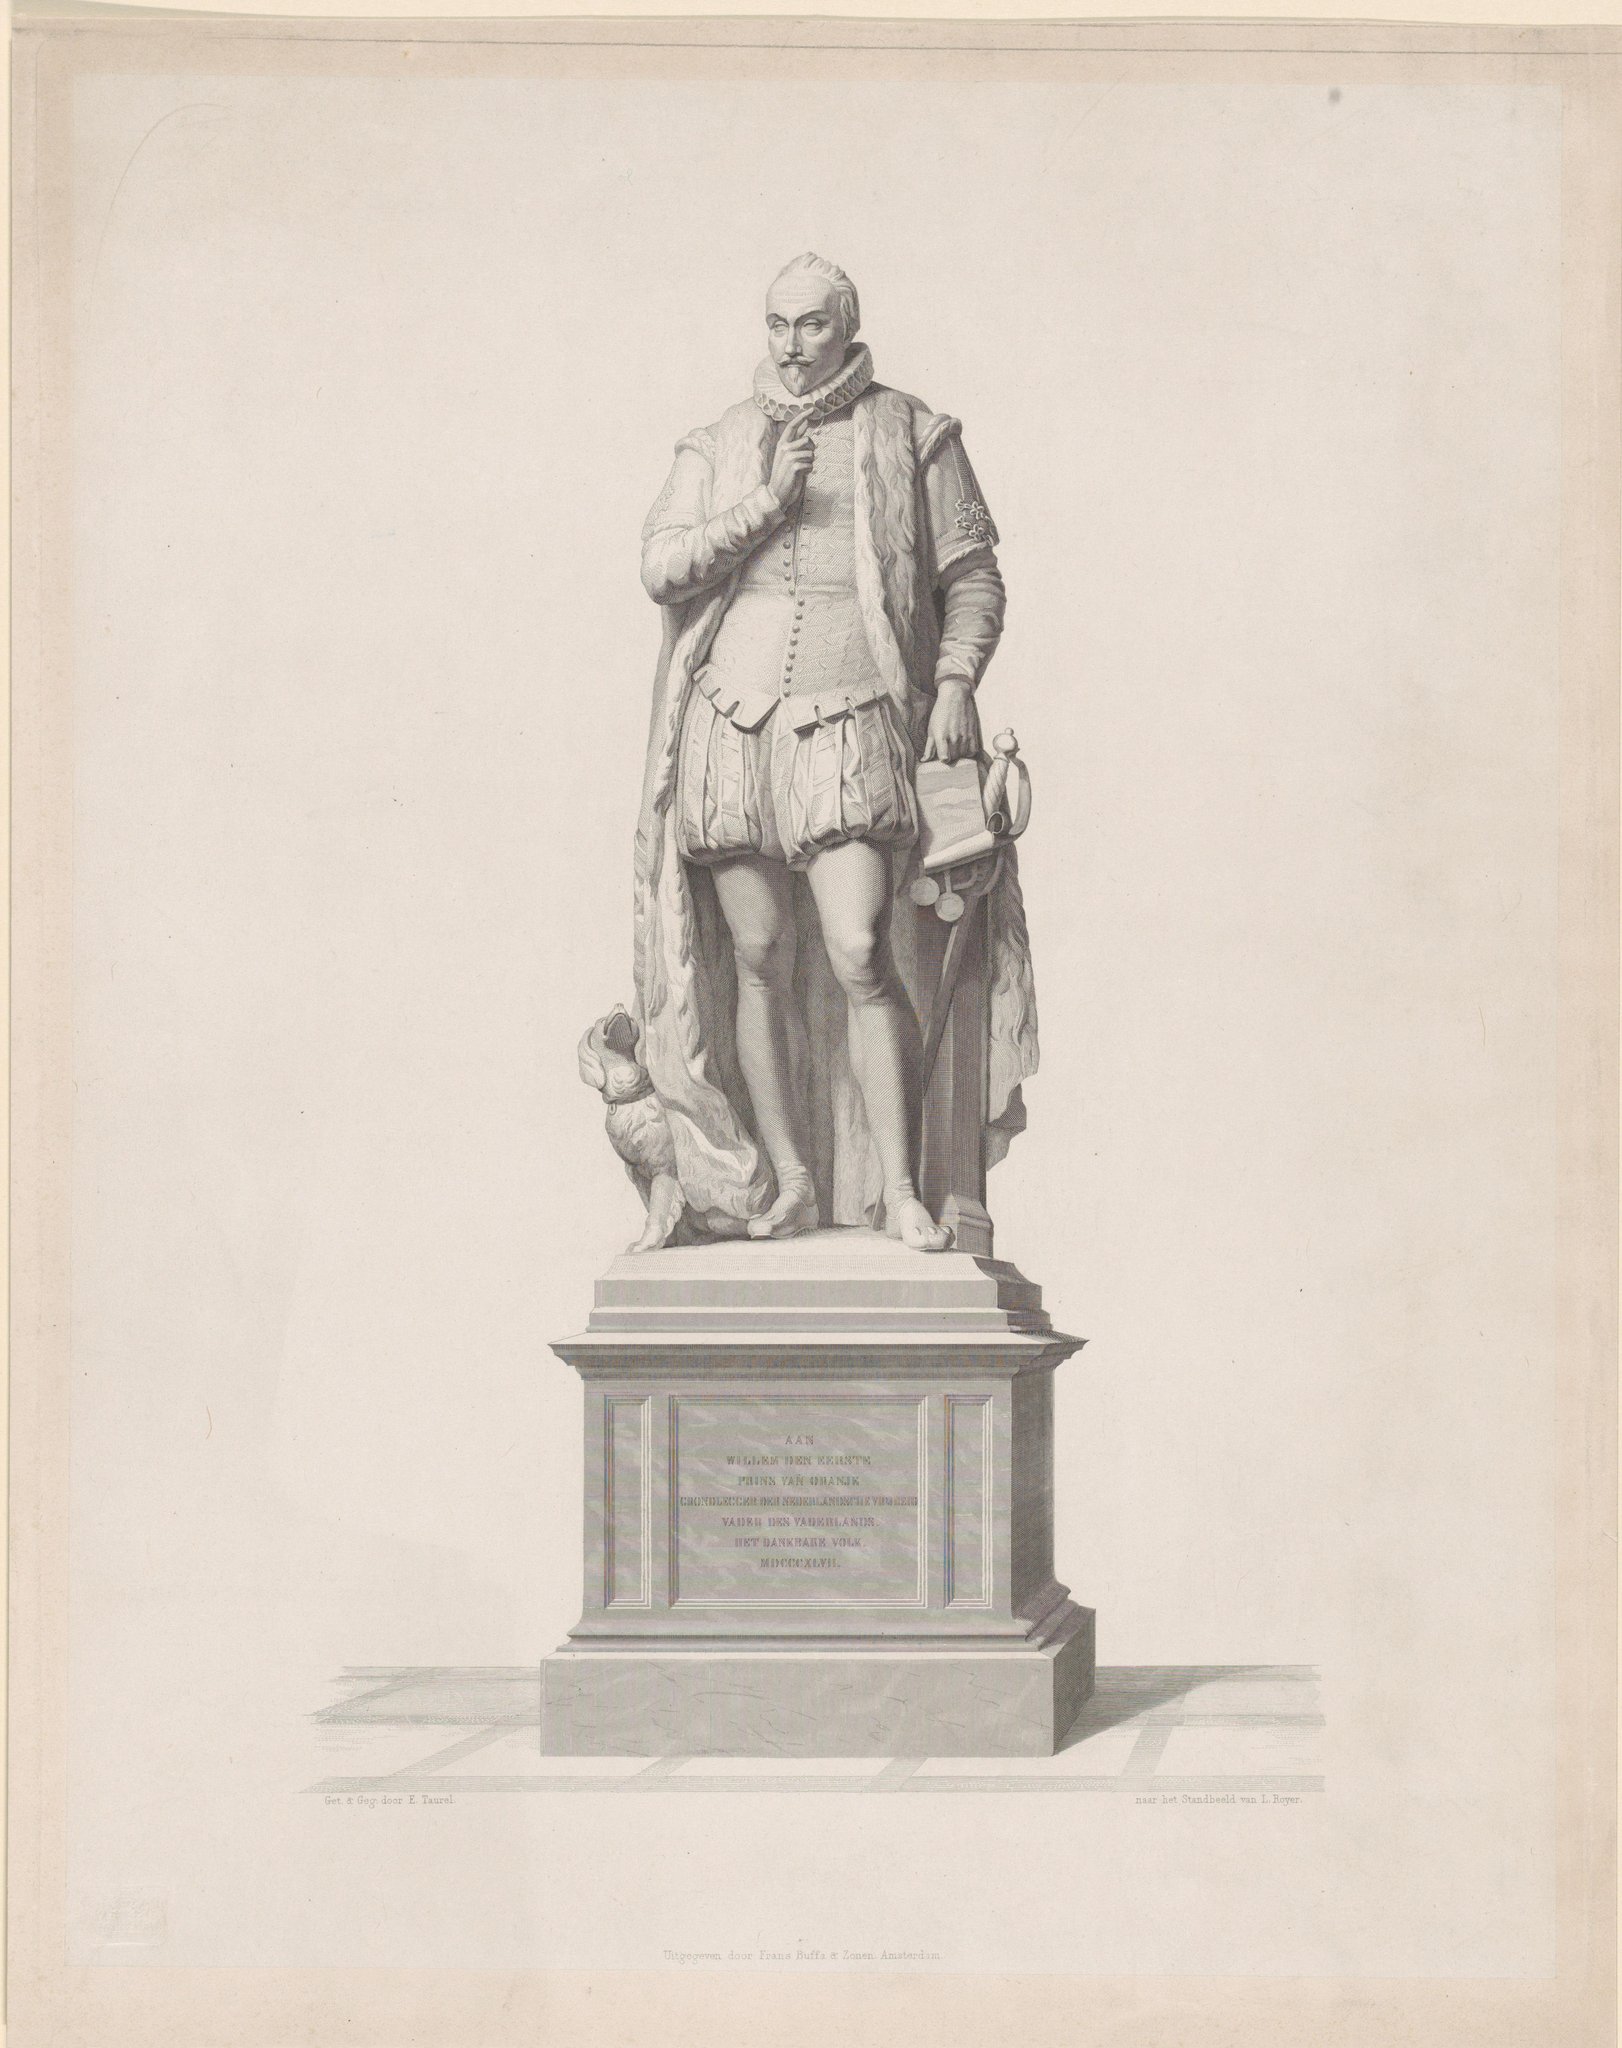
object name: print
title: Standbeeld van Willem I, prins van Oranje, op het Plein te Den Haag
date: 1848-1892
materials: paper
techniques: engraving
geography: amsterdam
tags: delft, william i (prince of orange), monument, statue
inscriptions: check stamp: ‘François Buffa & Fils’, collector's mark: Lugt 2228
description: De hier vermelde titel verwijst naar de hoogst verkregen titel van de geportretteerde, niet per se naar de titel die de geportretteerde op deze voorstelling draagt.